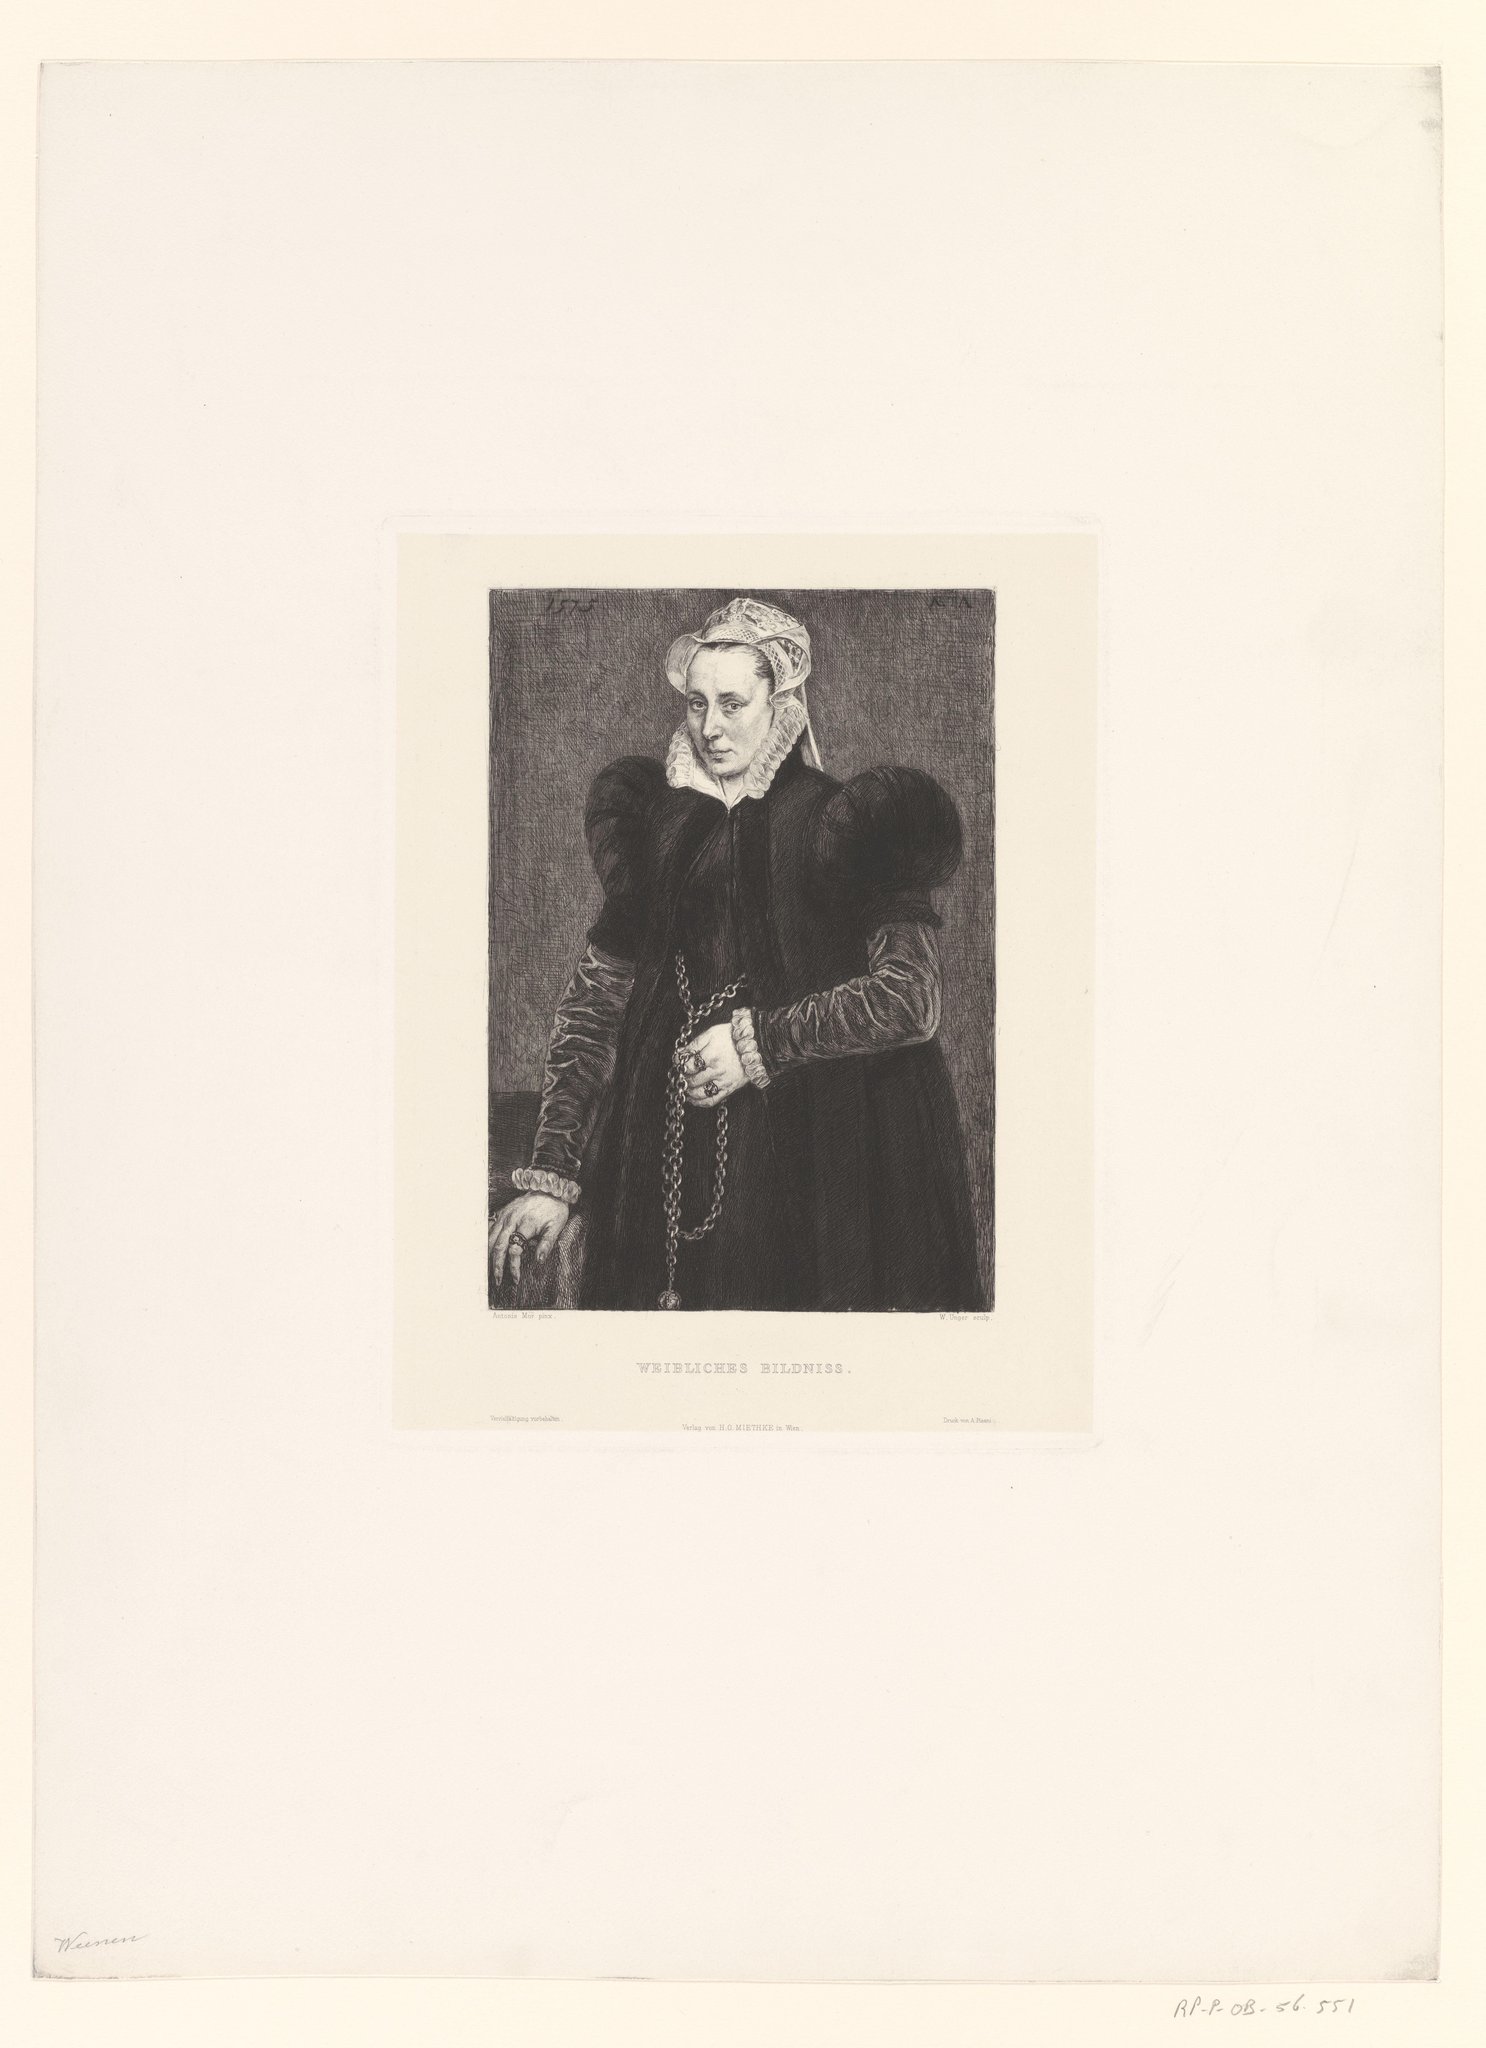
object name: print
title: Portret van een onbekende vrouw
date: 1861-1889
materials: paper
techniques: etching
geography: vienna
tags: historical persons not known by name - bb - woman, pendant, trinket, 'breloque'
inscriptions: collector's mark: Lugt 2228